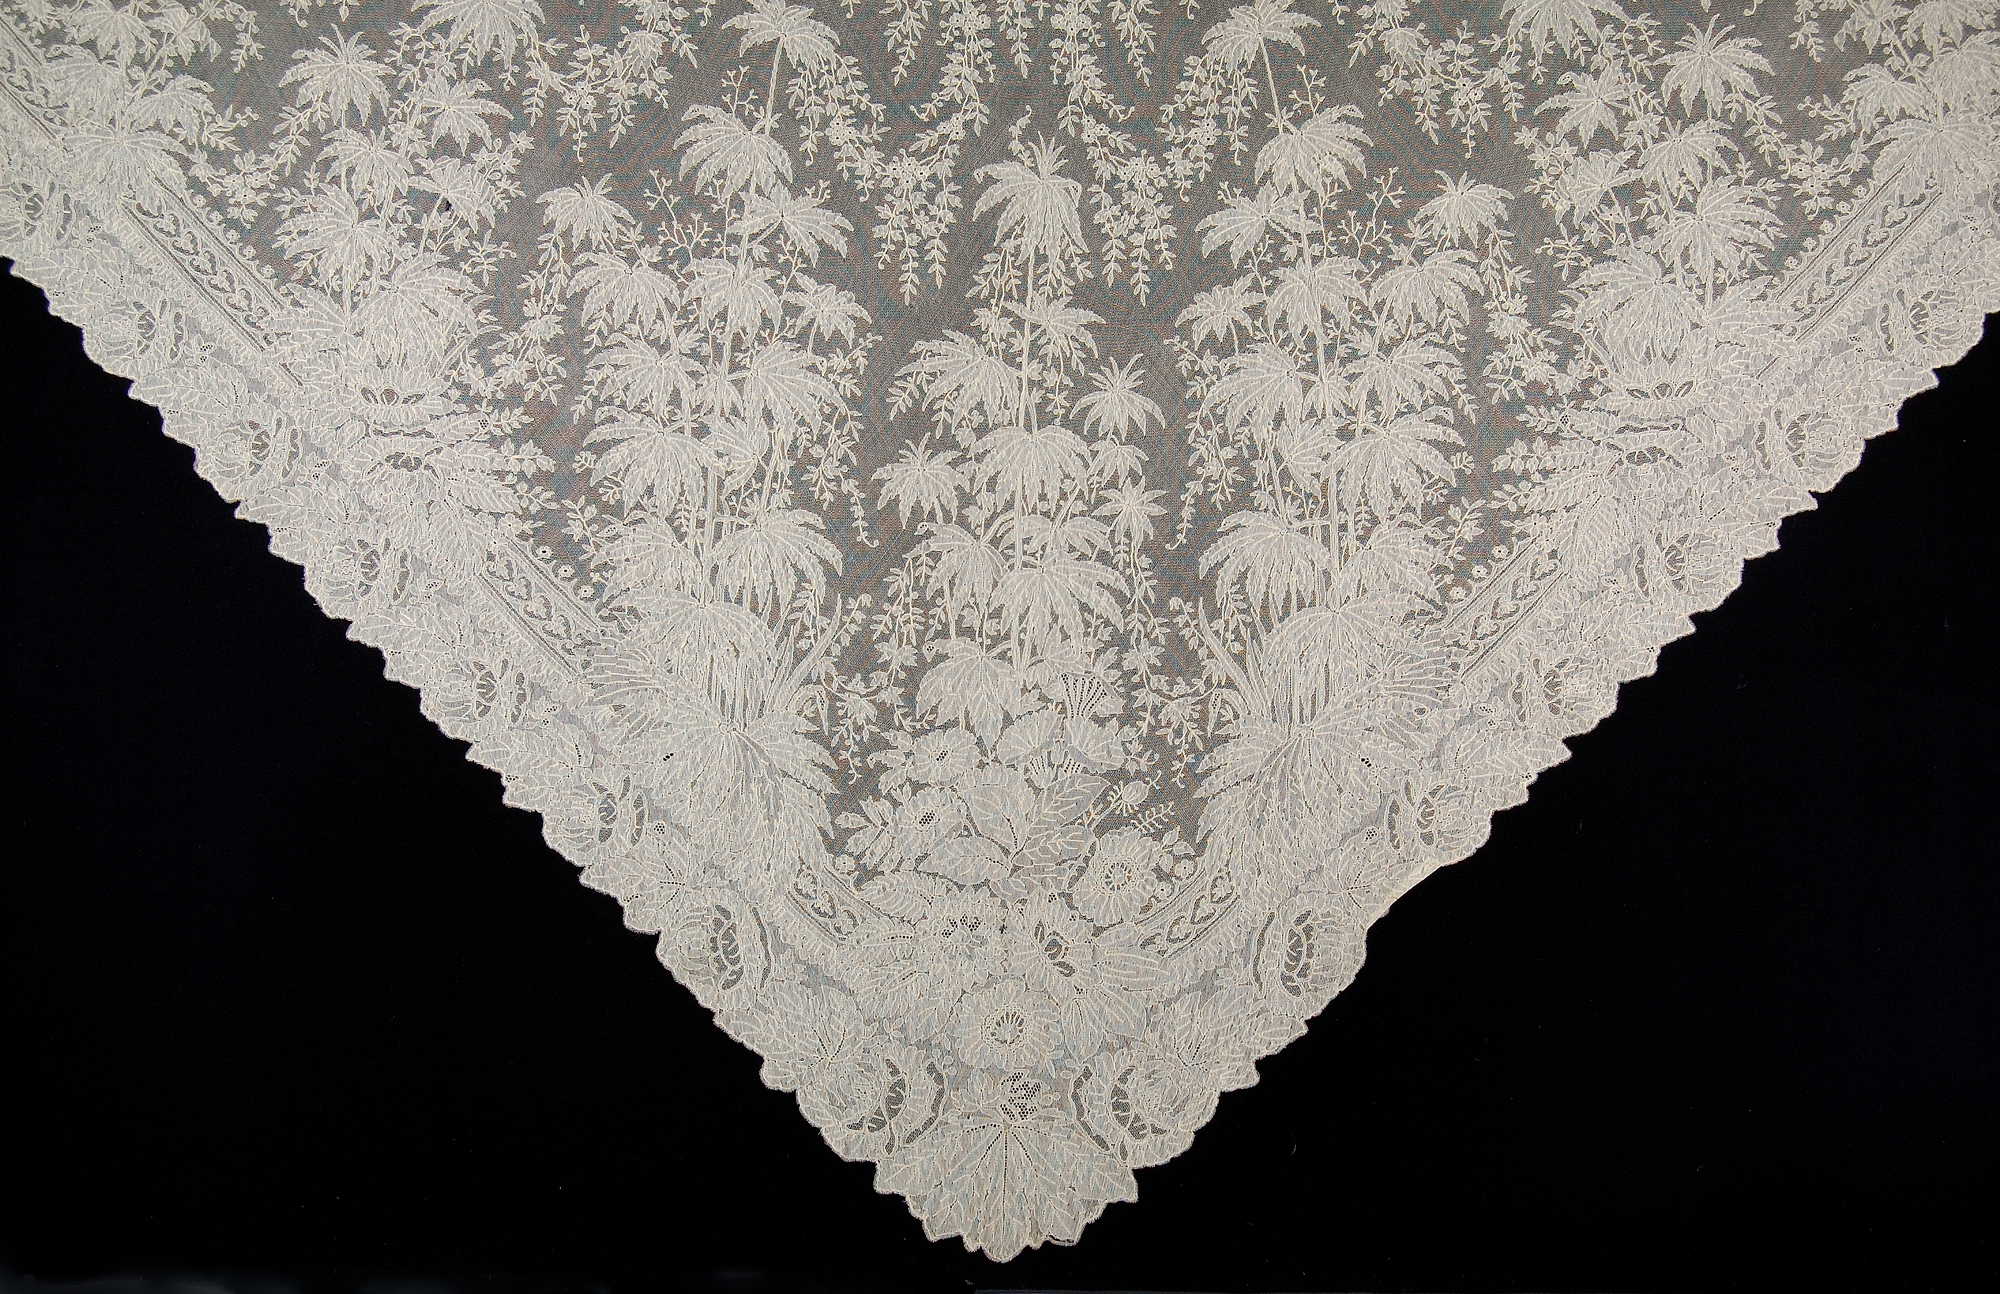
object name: shawl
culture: french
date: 1860-1870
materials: wool